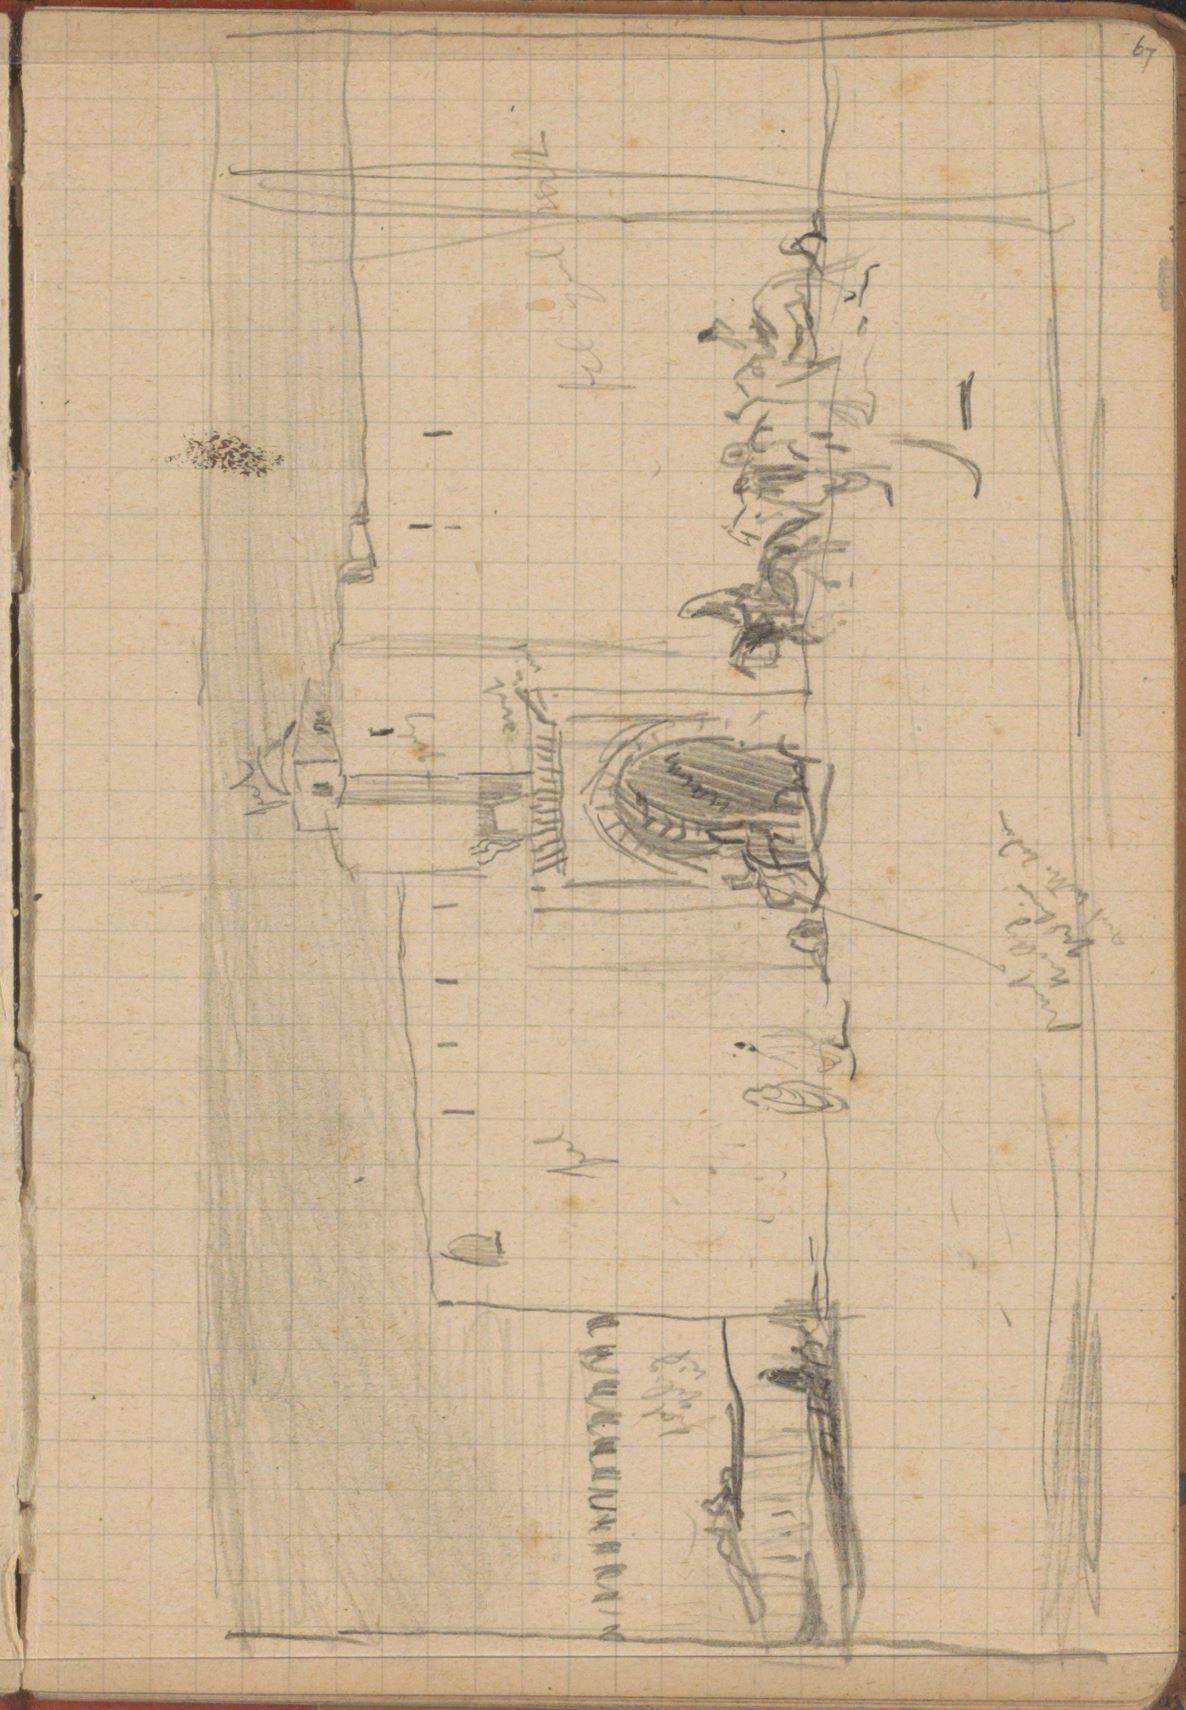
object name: sketchbook leaf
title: Figuren bij de poort van een gebouw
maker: marius bauer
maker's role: draughtsman, print maker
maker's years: 1867-1932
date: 1909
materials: pencil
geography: tunisia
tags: gate, entrance, street (+ city(-scape) with figures, staffage)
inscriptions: kleurnotitie, handgeschreven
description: Mogelijk een moskee of deel van een stadsmuur. Pagina 67 uit een schetsboek met 67 bladen.